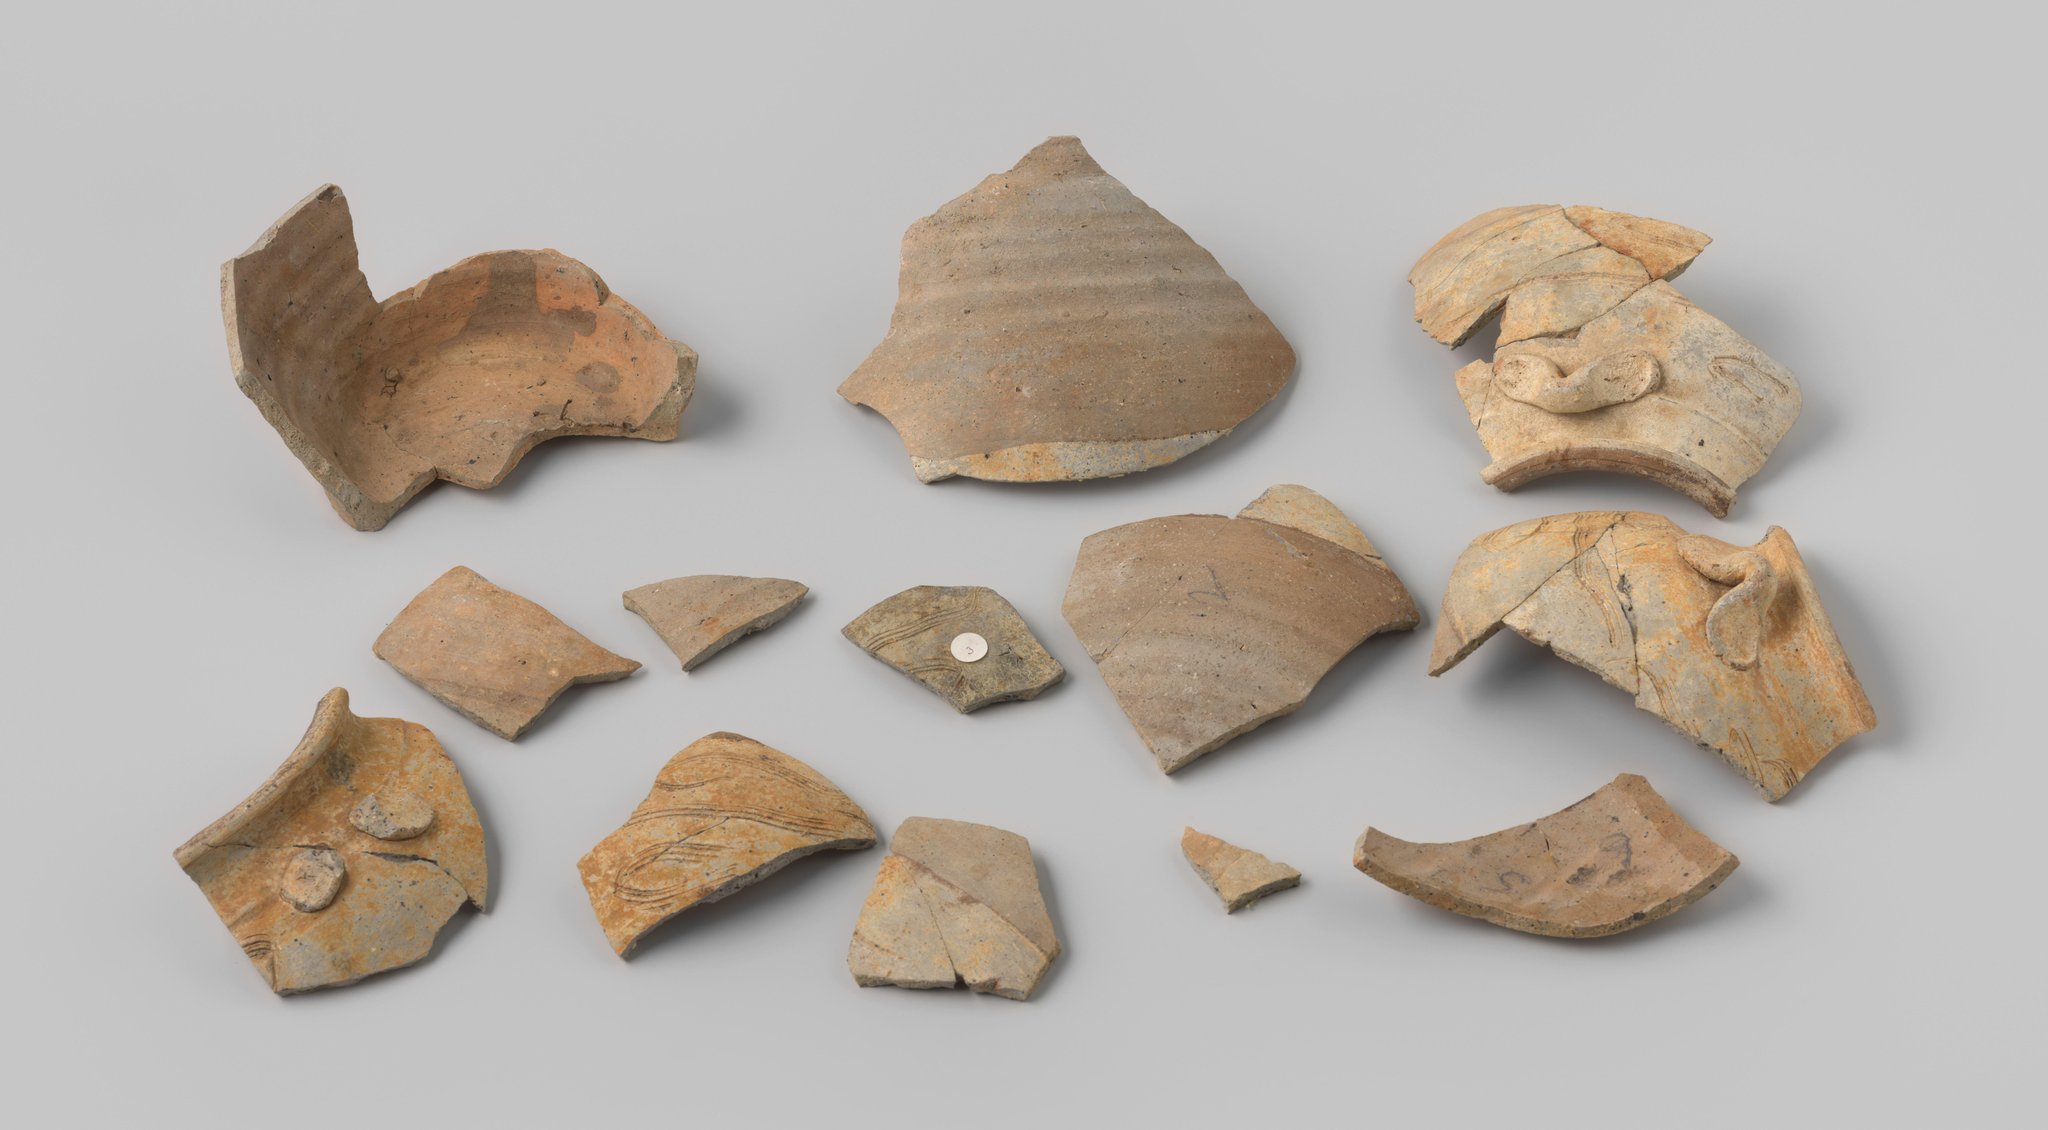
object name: sherd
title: Martavaan uit V.O.C.-schip de 'Witte Leeuw'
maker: Anonymous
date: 1613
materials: porcelain, stoneware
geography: southeast asia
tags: verenigde oostindische compagnie, sint-helena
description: A jar. The base of this particularly coarse jar is evenly finished. The ears are connected by a slightly concave band of about 1 cm wide. The surface of the outside lip, neck and upper half of the shoulder is coloured light grey at places where the glaze has worn off. The surface of the base is slightly pink. There is a horizontal incision band with four wavy lines 4 cm beneath the ears, Under and above this band there are loops with wavy lines.